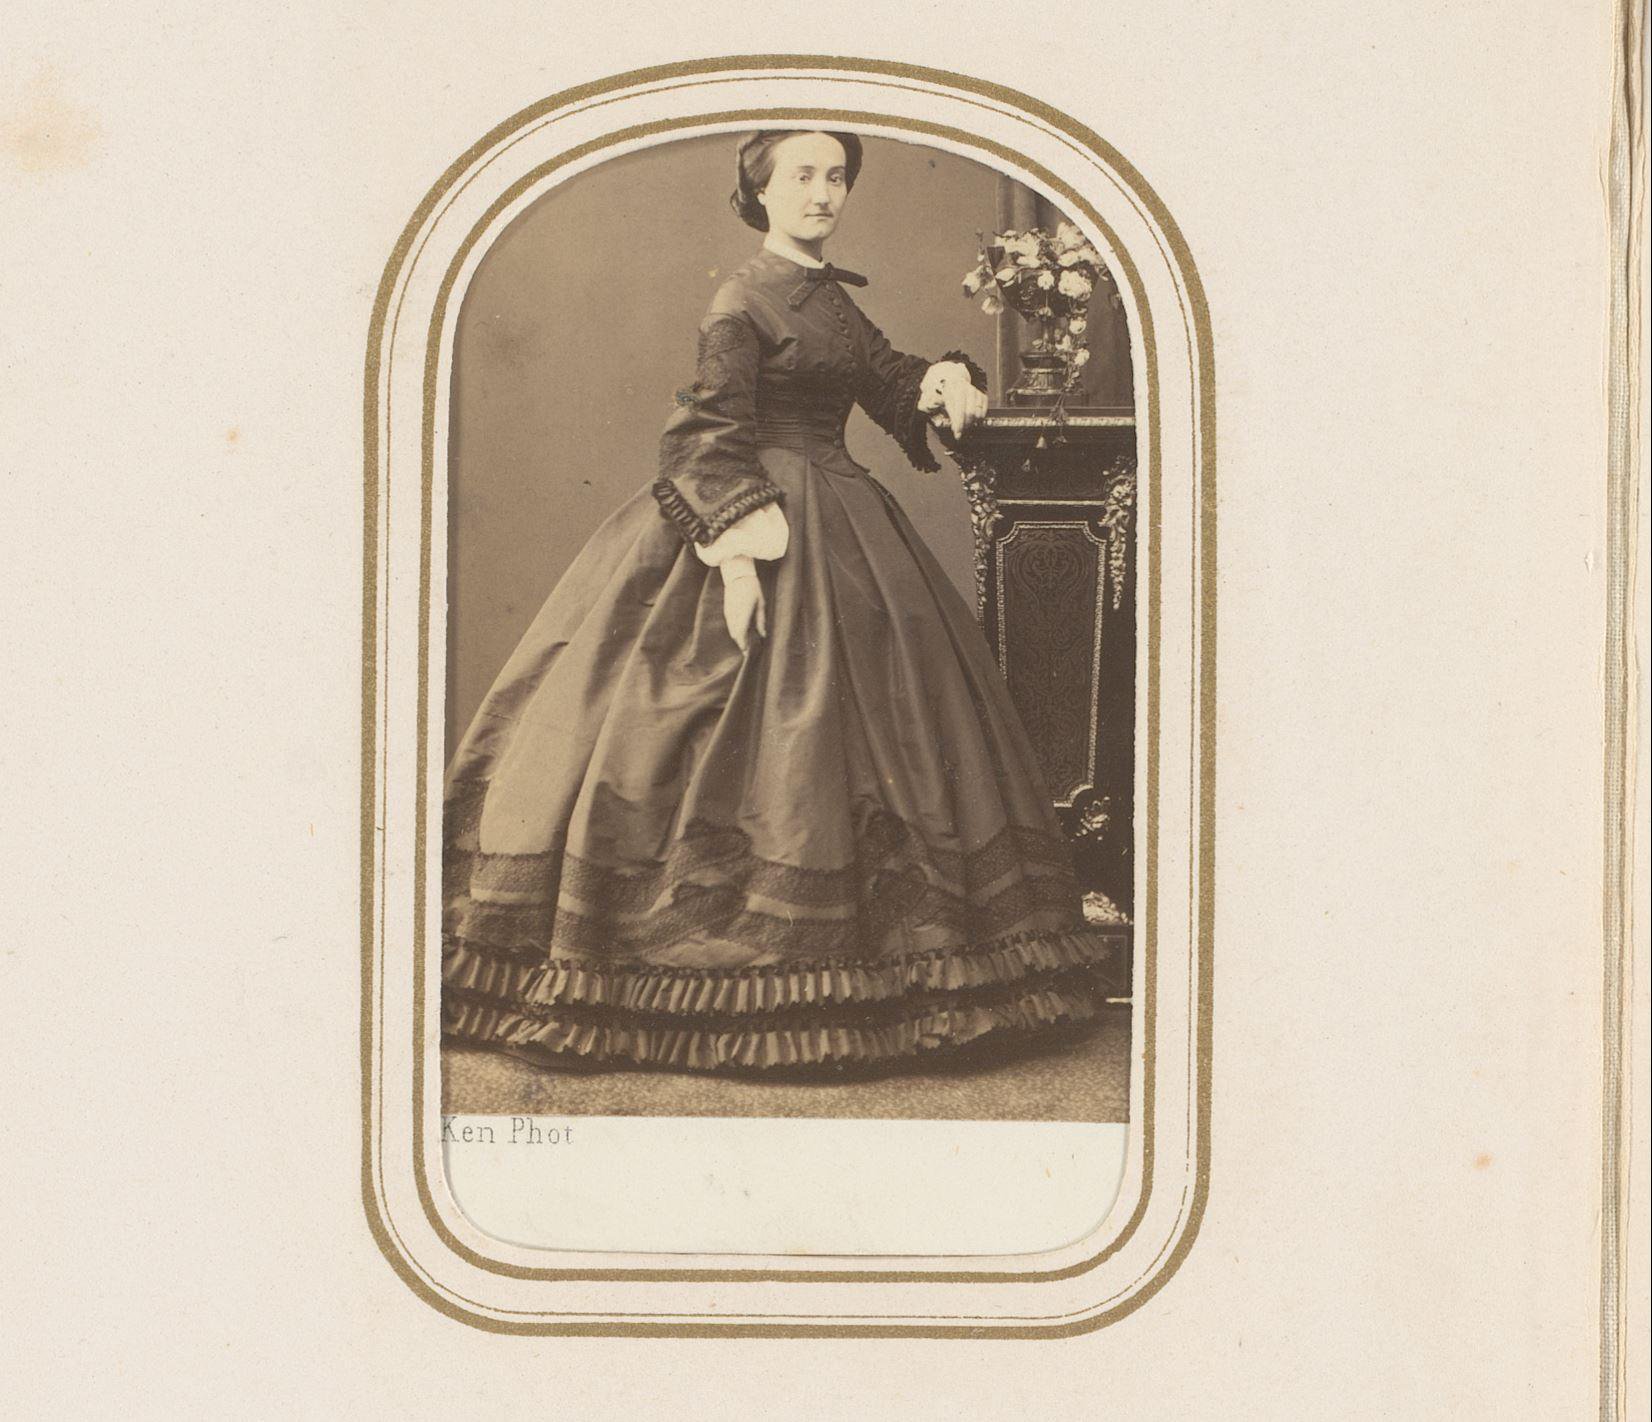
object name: carte de visite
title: Portret van een vrouw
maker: alexandre ken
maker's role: fotograaf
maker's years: 1828-1874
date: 1850-1874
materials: cardboard, photographic support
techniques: albumen print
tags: historical persons, standing figure - aa - female human figure, dress, gown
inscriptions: inscription: ‘A. Ken/ Photographe/ Boulevt Montmartre 10/ Paris’